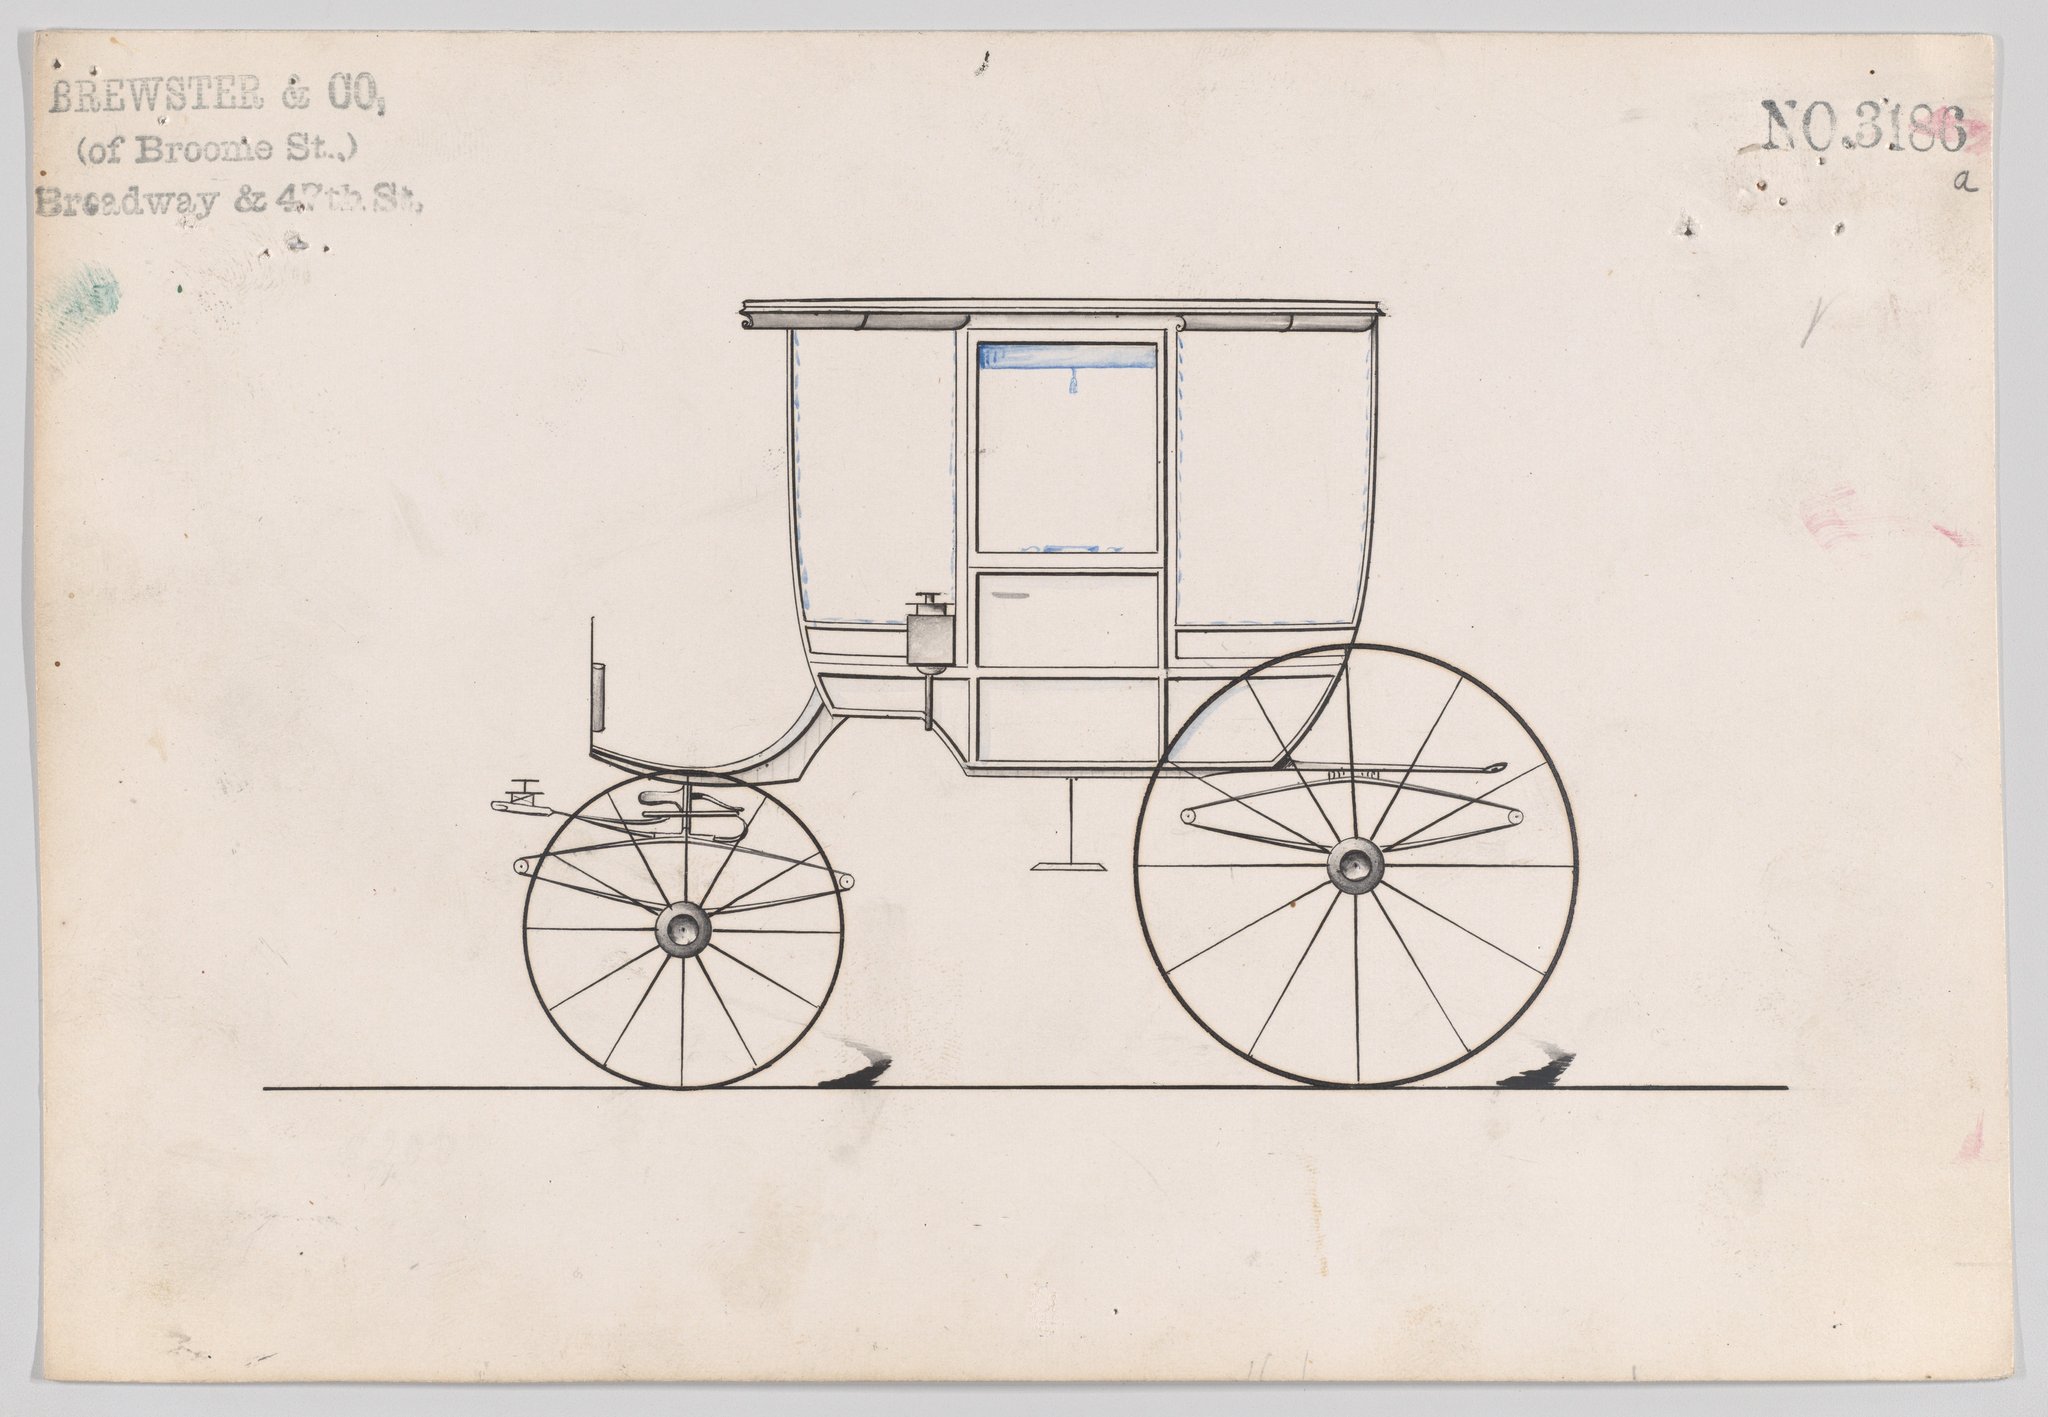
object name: drawing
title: Design for 6 seat Rockaway, no. 3186a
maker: brewster & co.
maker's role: manufacturer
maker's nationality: american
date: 1876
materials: gouache, ink, watercolor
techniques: pen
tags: carriages